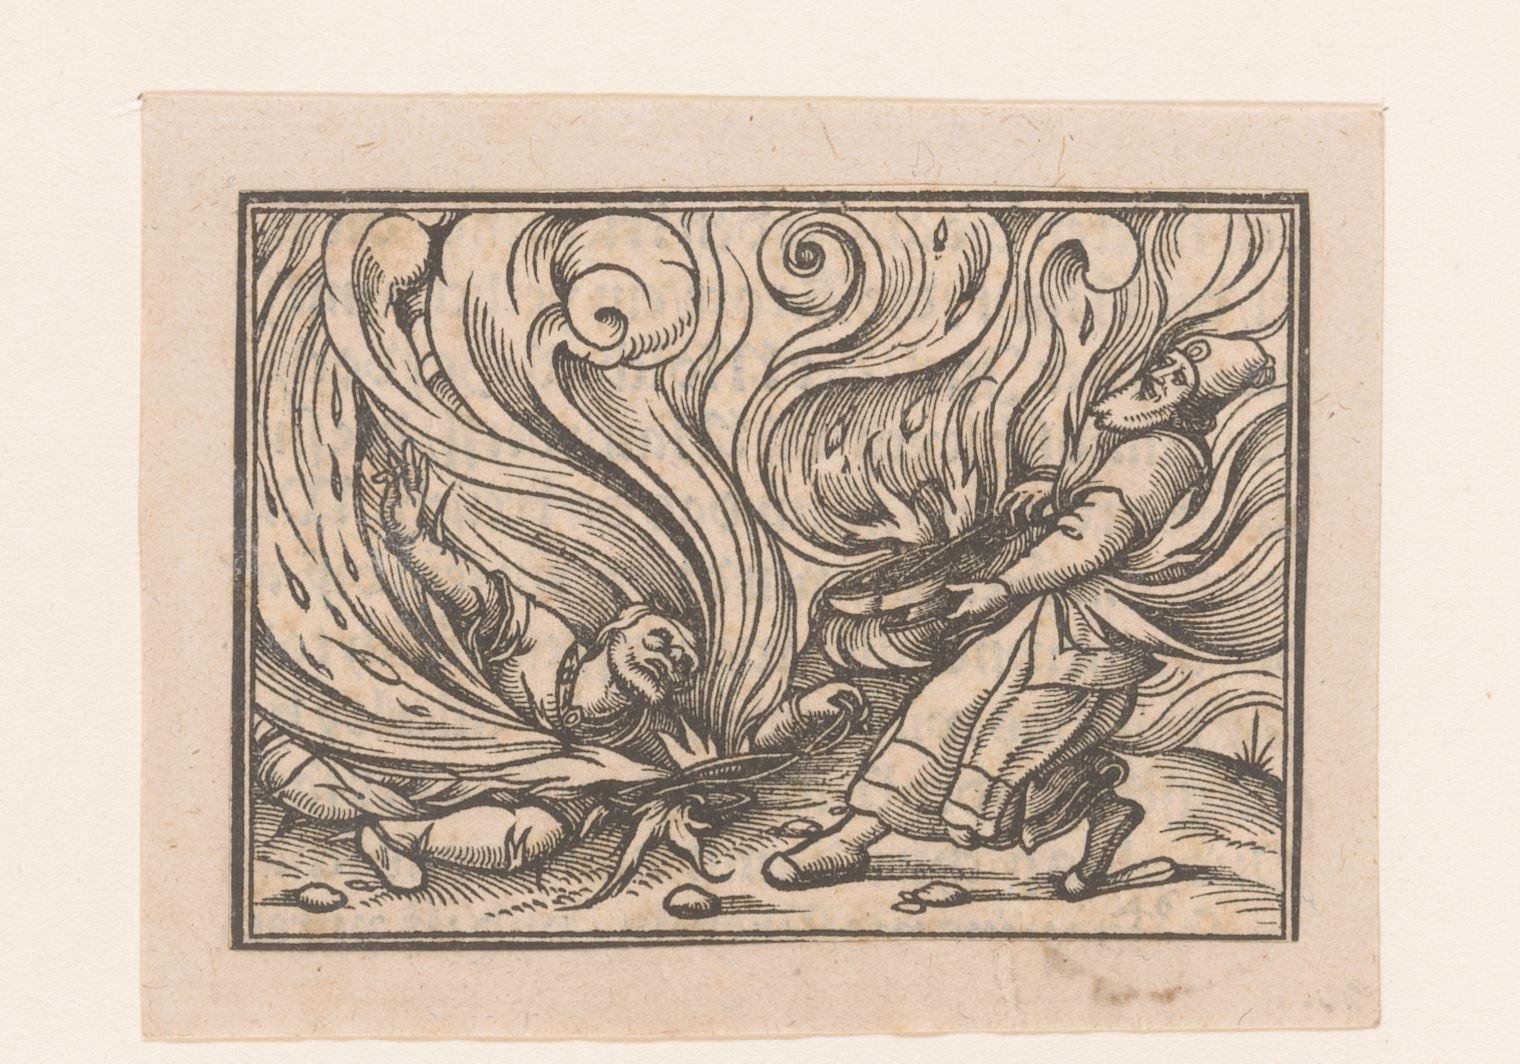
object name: book illustration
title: Kopieën naar Holbein's bijbelillustraties voor de Biblia Utriusque Testamenti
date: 1522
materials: paper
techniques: woodcut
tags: two sons of aaron, nadab and abihu, offer incense in their censers to god, who punishes them for this by sending a fire that kills them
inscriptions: collector's mark: Lugt 240, collector's mark: Lugt 240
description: Mogelijk een kopie van een prent van Hans Holbein de jongere. Niet uit de Icones historiarum Veteris Testamenti van 1538. Deze kopie mogelijk uit: Biblia sacra iuxta vulgatam. Parijs: Jean Benoît, 1552. Ook aanwezig in de Herzog August Bibliothek: http://diglib.hab.de?grafik=graph-res-d-326-1.